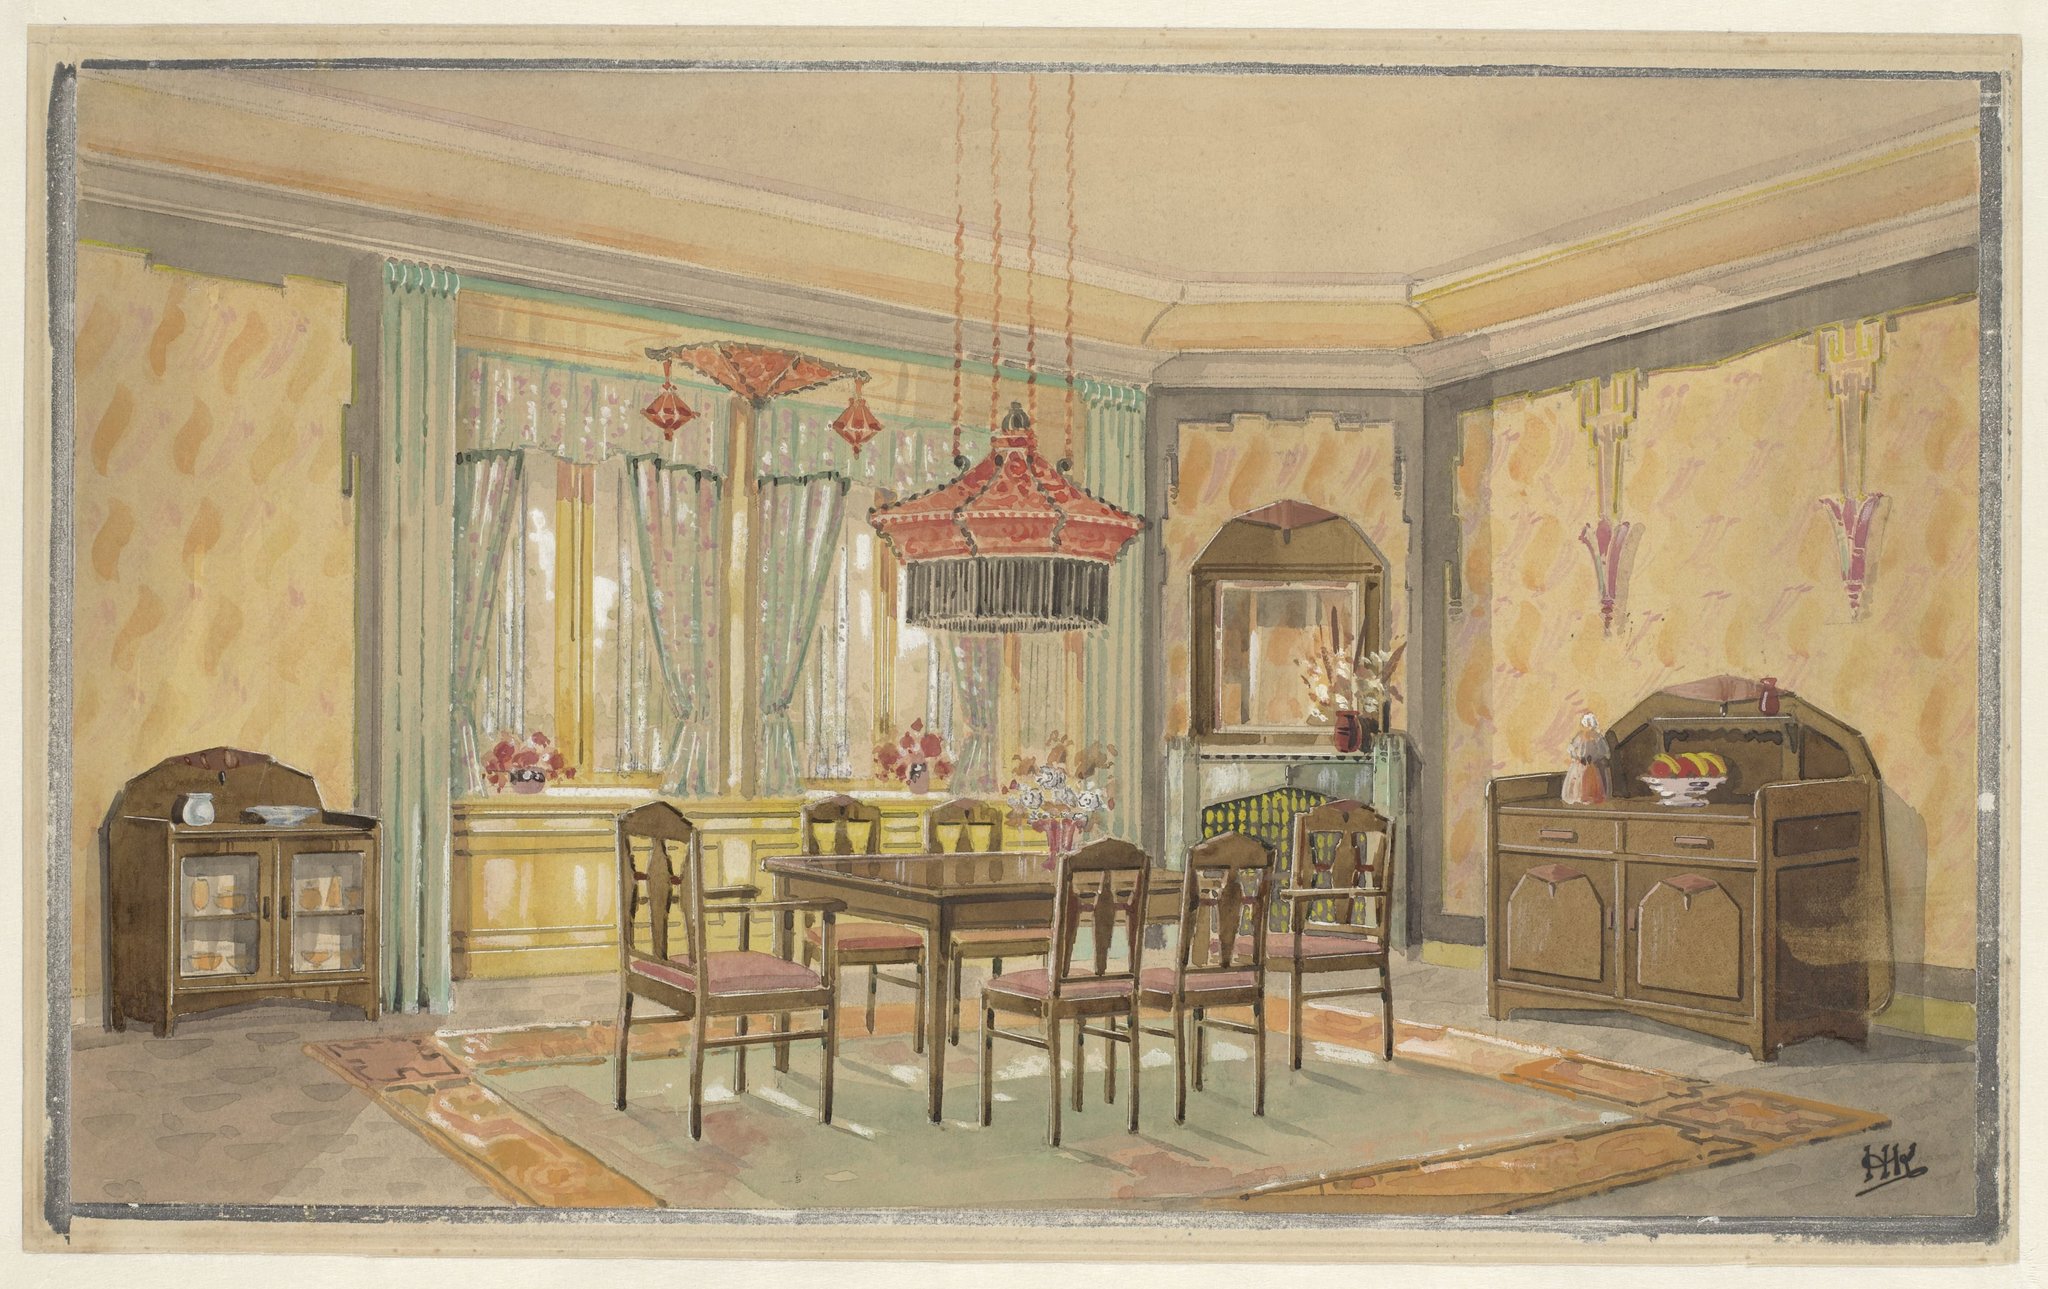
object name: watercolor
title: Eetkamer met gele wanden en rode lamp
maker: monogrammist hk (nederland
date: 1925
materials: paper, watercolor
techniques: brush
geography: amsterdam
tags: dining-room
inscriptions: monogram: ‘HK’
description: Mogelijk is dit een demonstratietekeningen van een meubel- of inrichtingszaak.